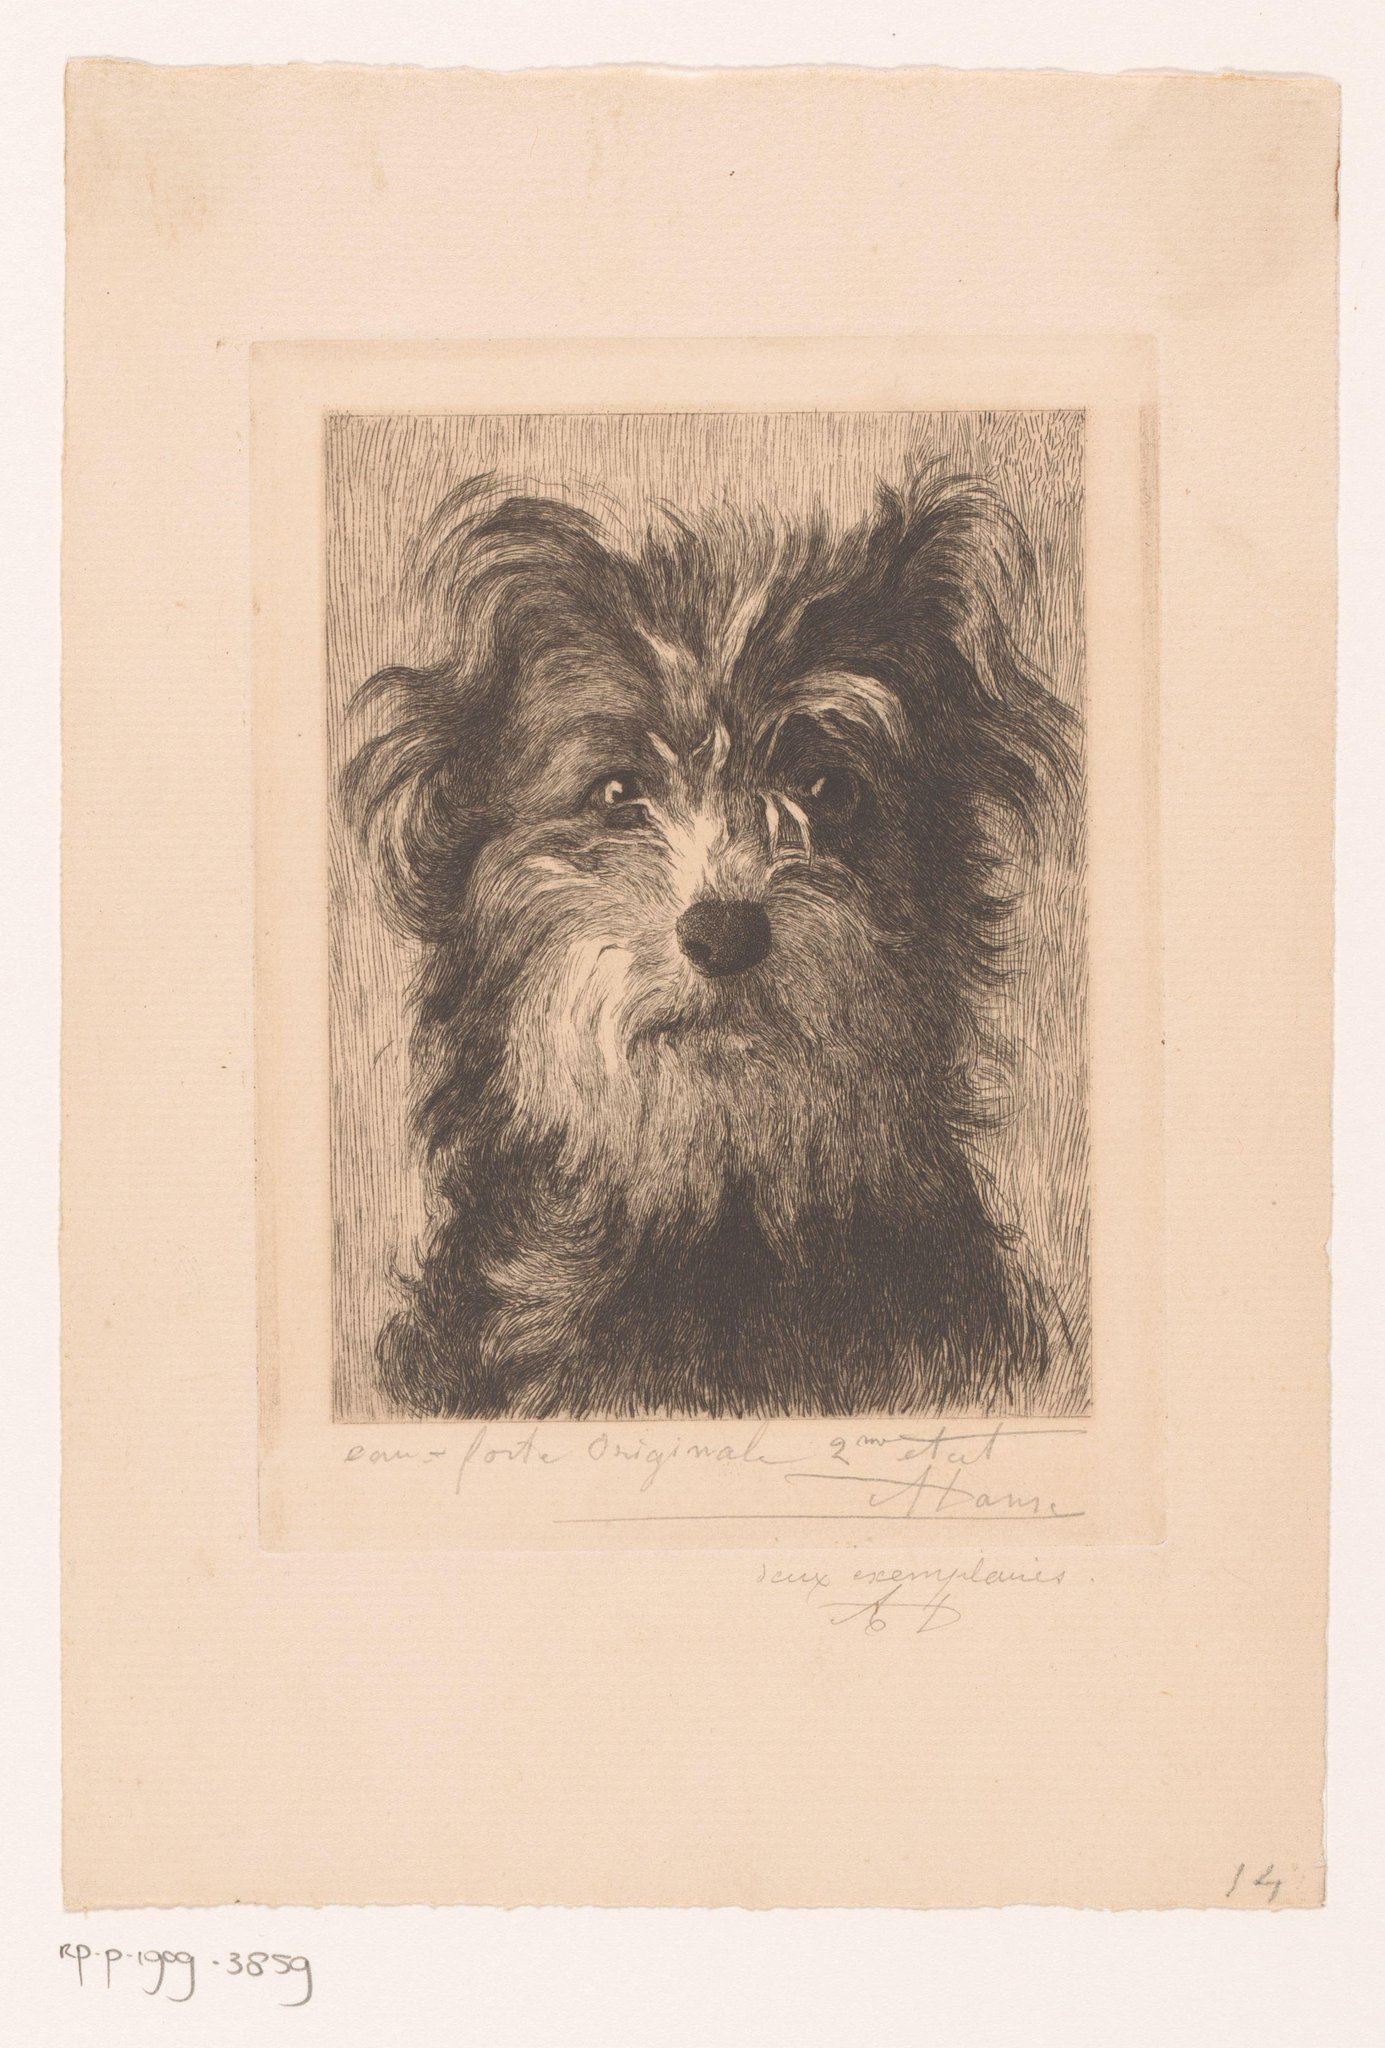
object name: print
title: Kop van een smoushond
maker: auguste danse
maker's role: print maker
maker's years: 1829-1929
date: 1896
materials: paper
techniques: etching, intaglio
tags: dog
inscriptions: collector's mark: Lugt 2228, annotation: ‘eau-forte originale 2me etat; deux exemplaires’